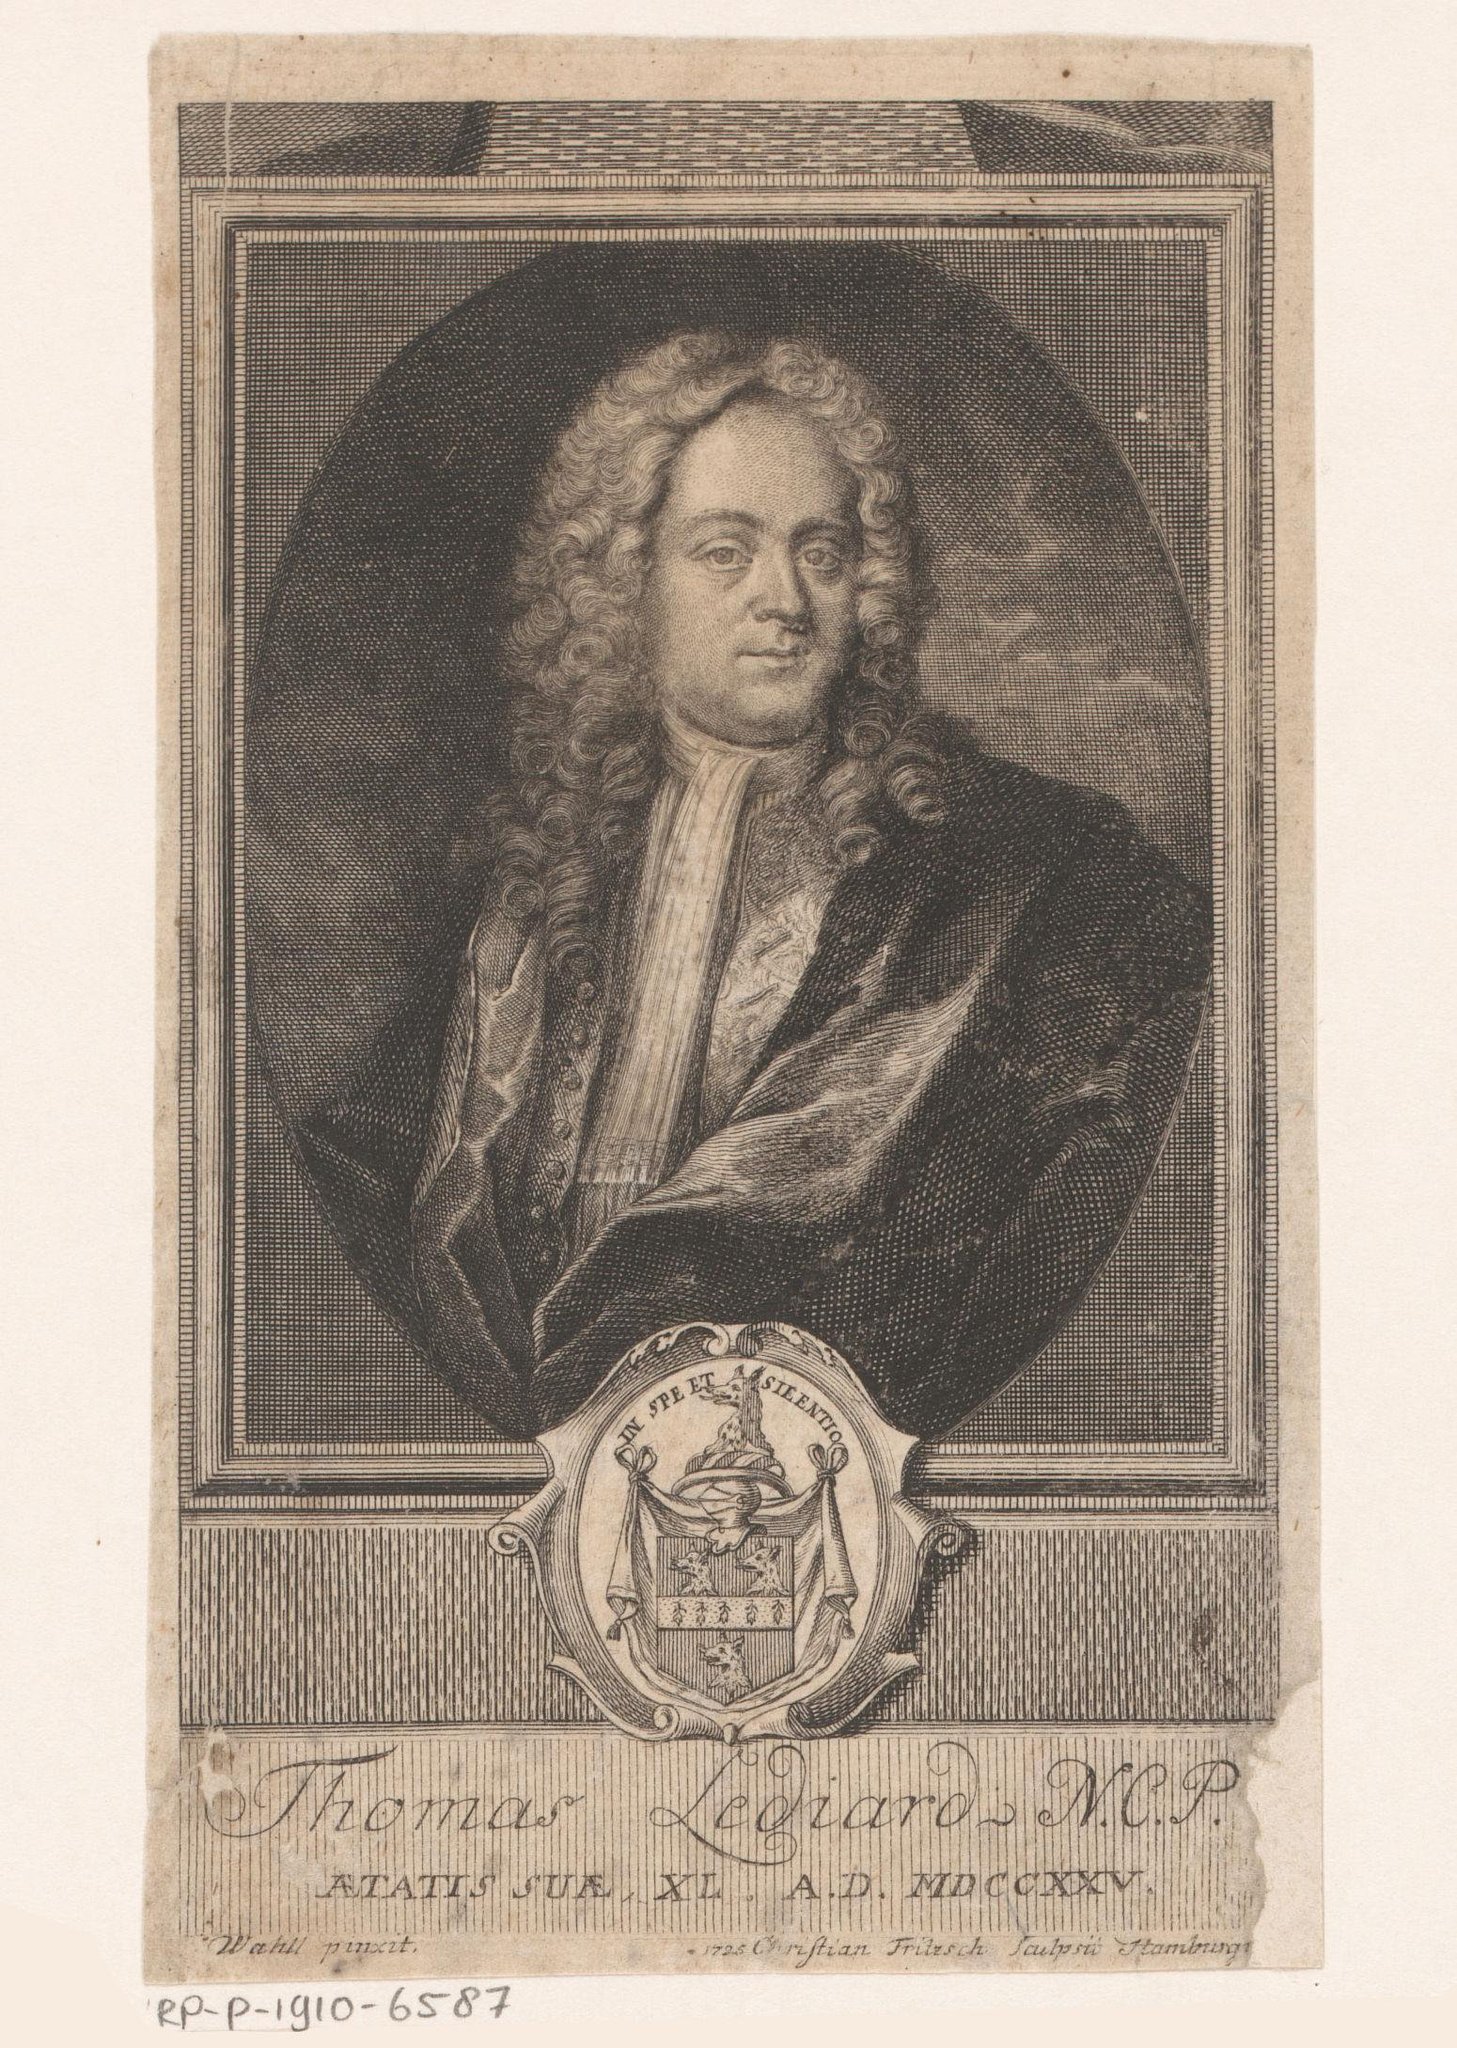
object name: print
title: Portret van Thomas Lediard op 40-jarige leeftijd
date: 1725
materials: paper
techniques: engraving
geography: hamburg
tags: london, historical persons, armorial bearing, heraldry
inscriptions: collector's mark: Lugt 2228